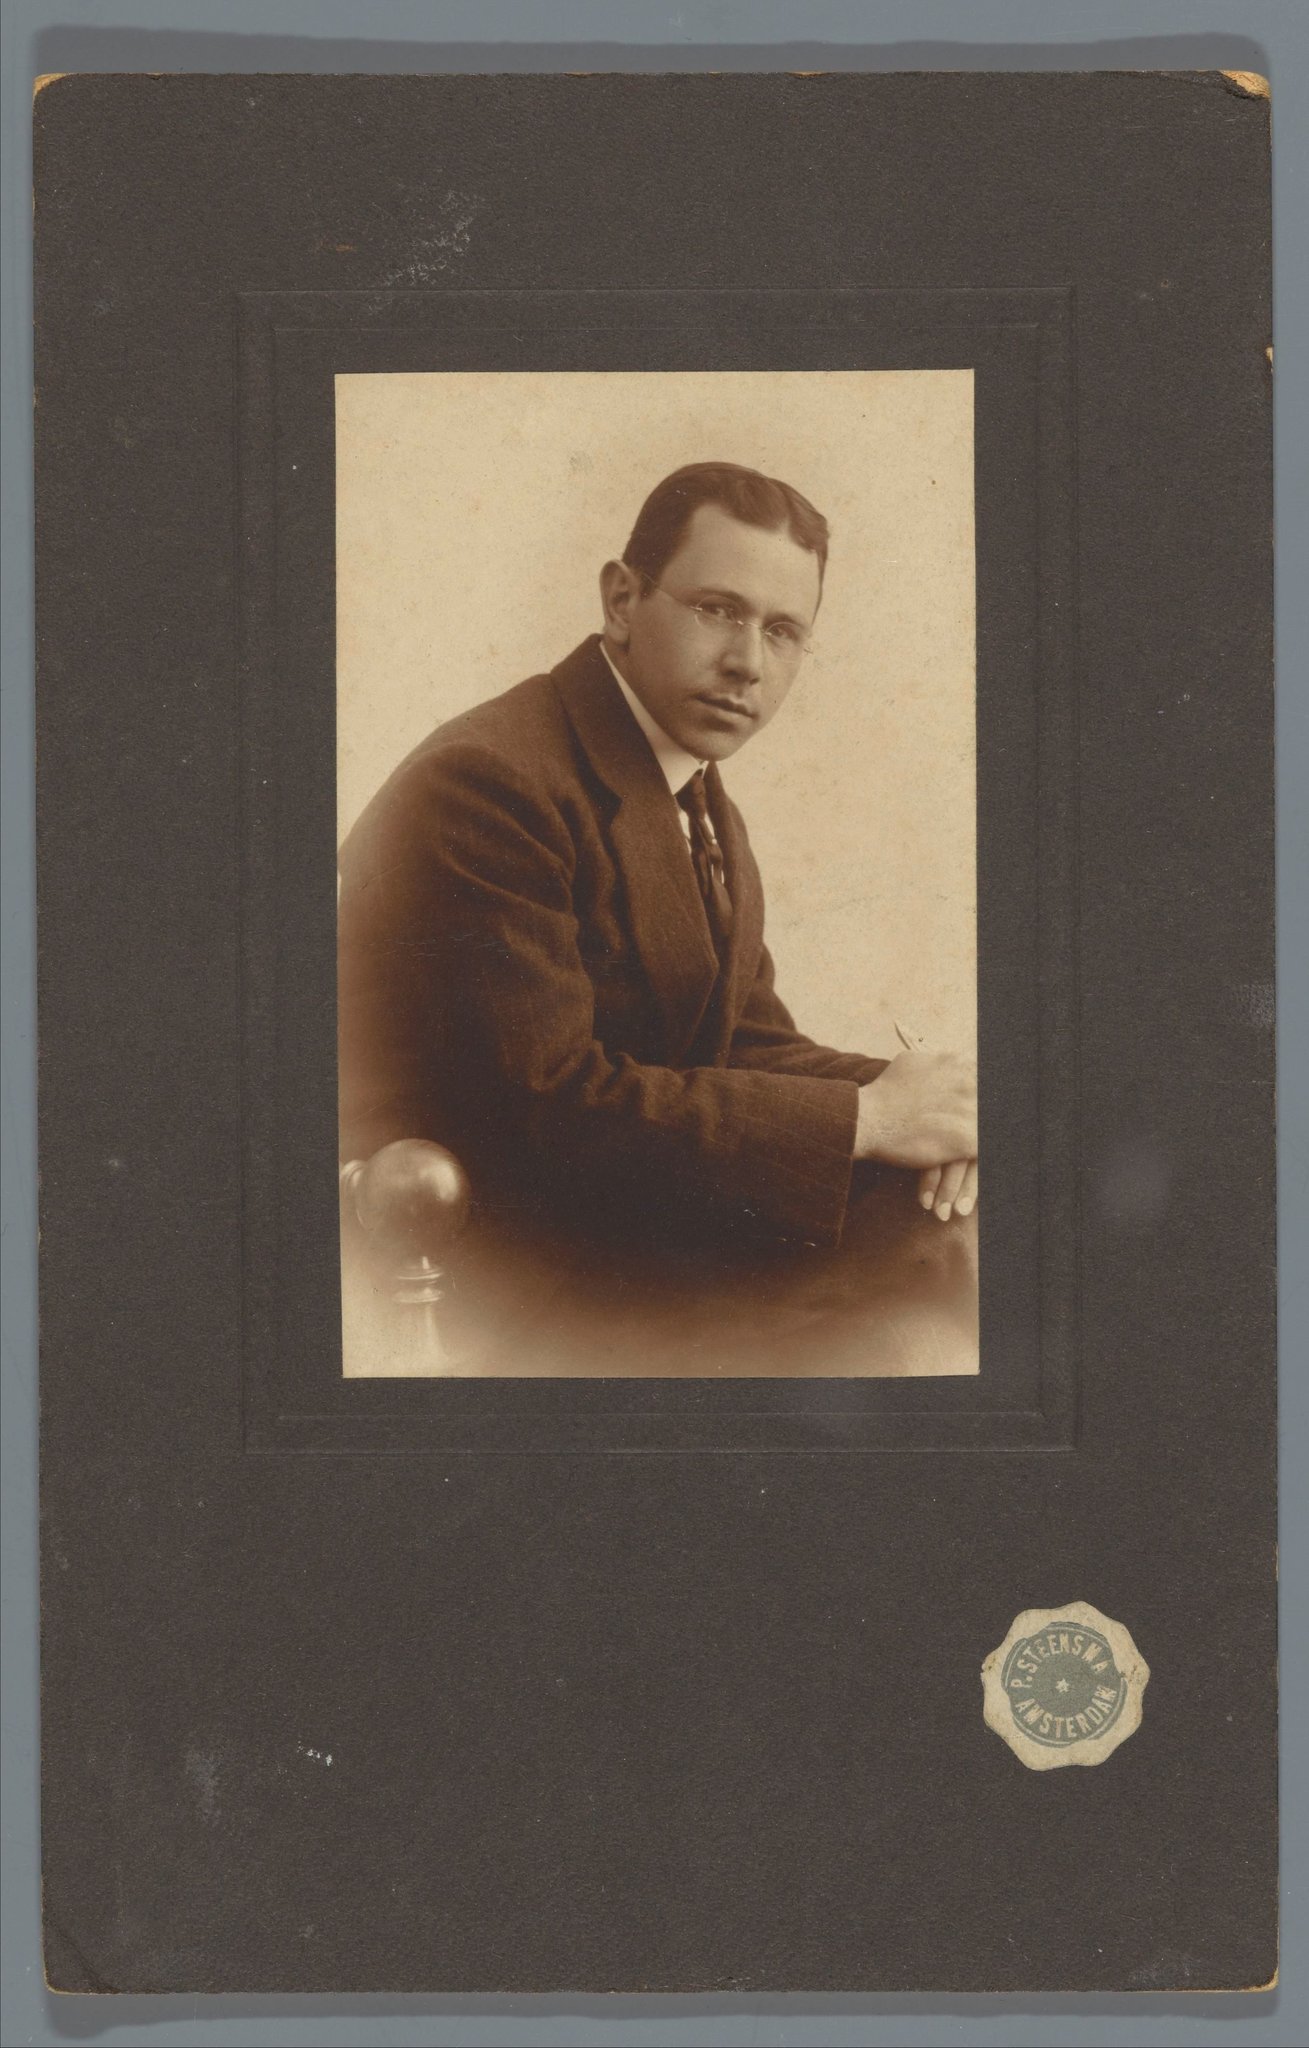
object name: photograph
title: Portret van een onbekende man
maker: pier steensma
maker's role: fotograaf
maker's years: 1879-1931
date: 1910-1920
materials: cardboard, photographic support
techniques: gelatin silver print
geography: amsterdam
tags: adult man